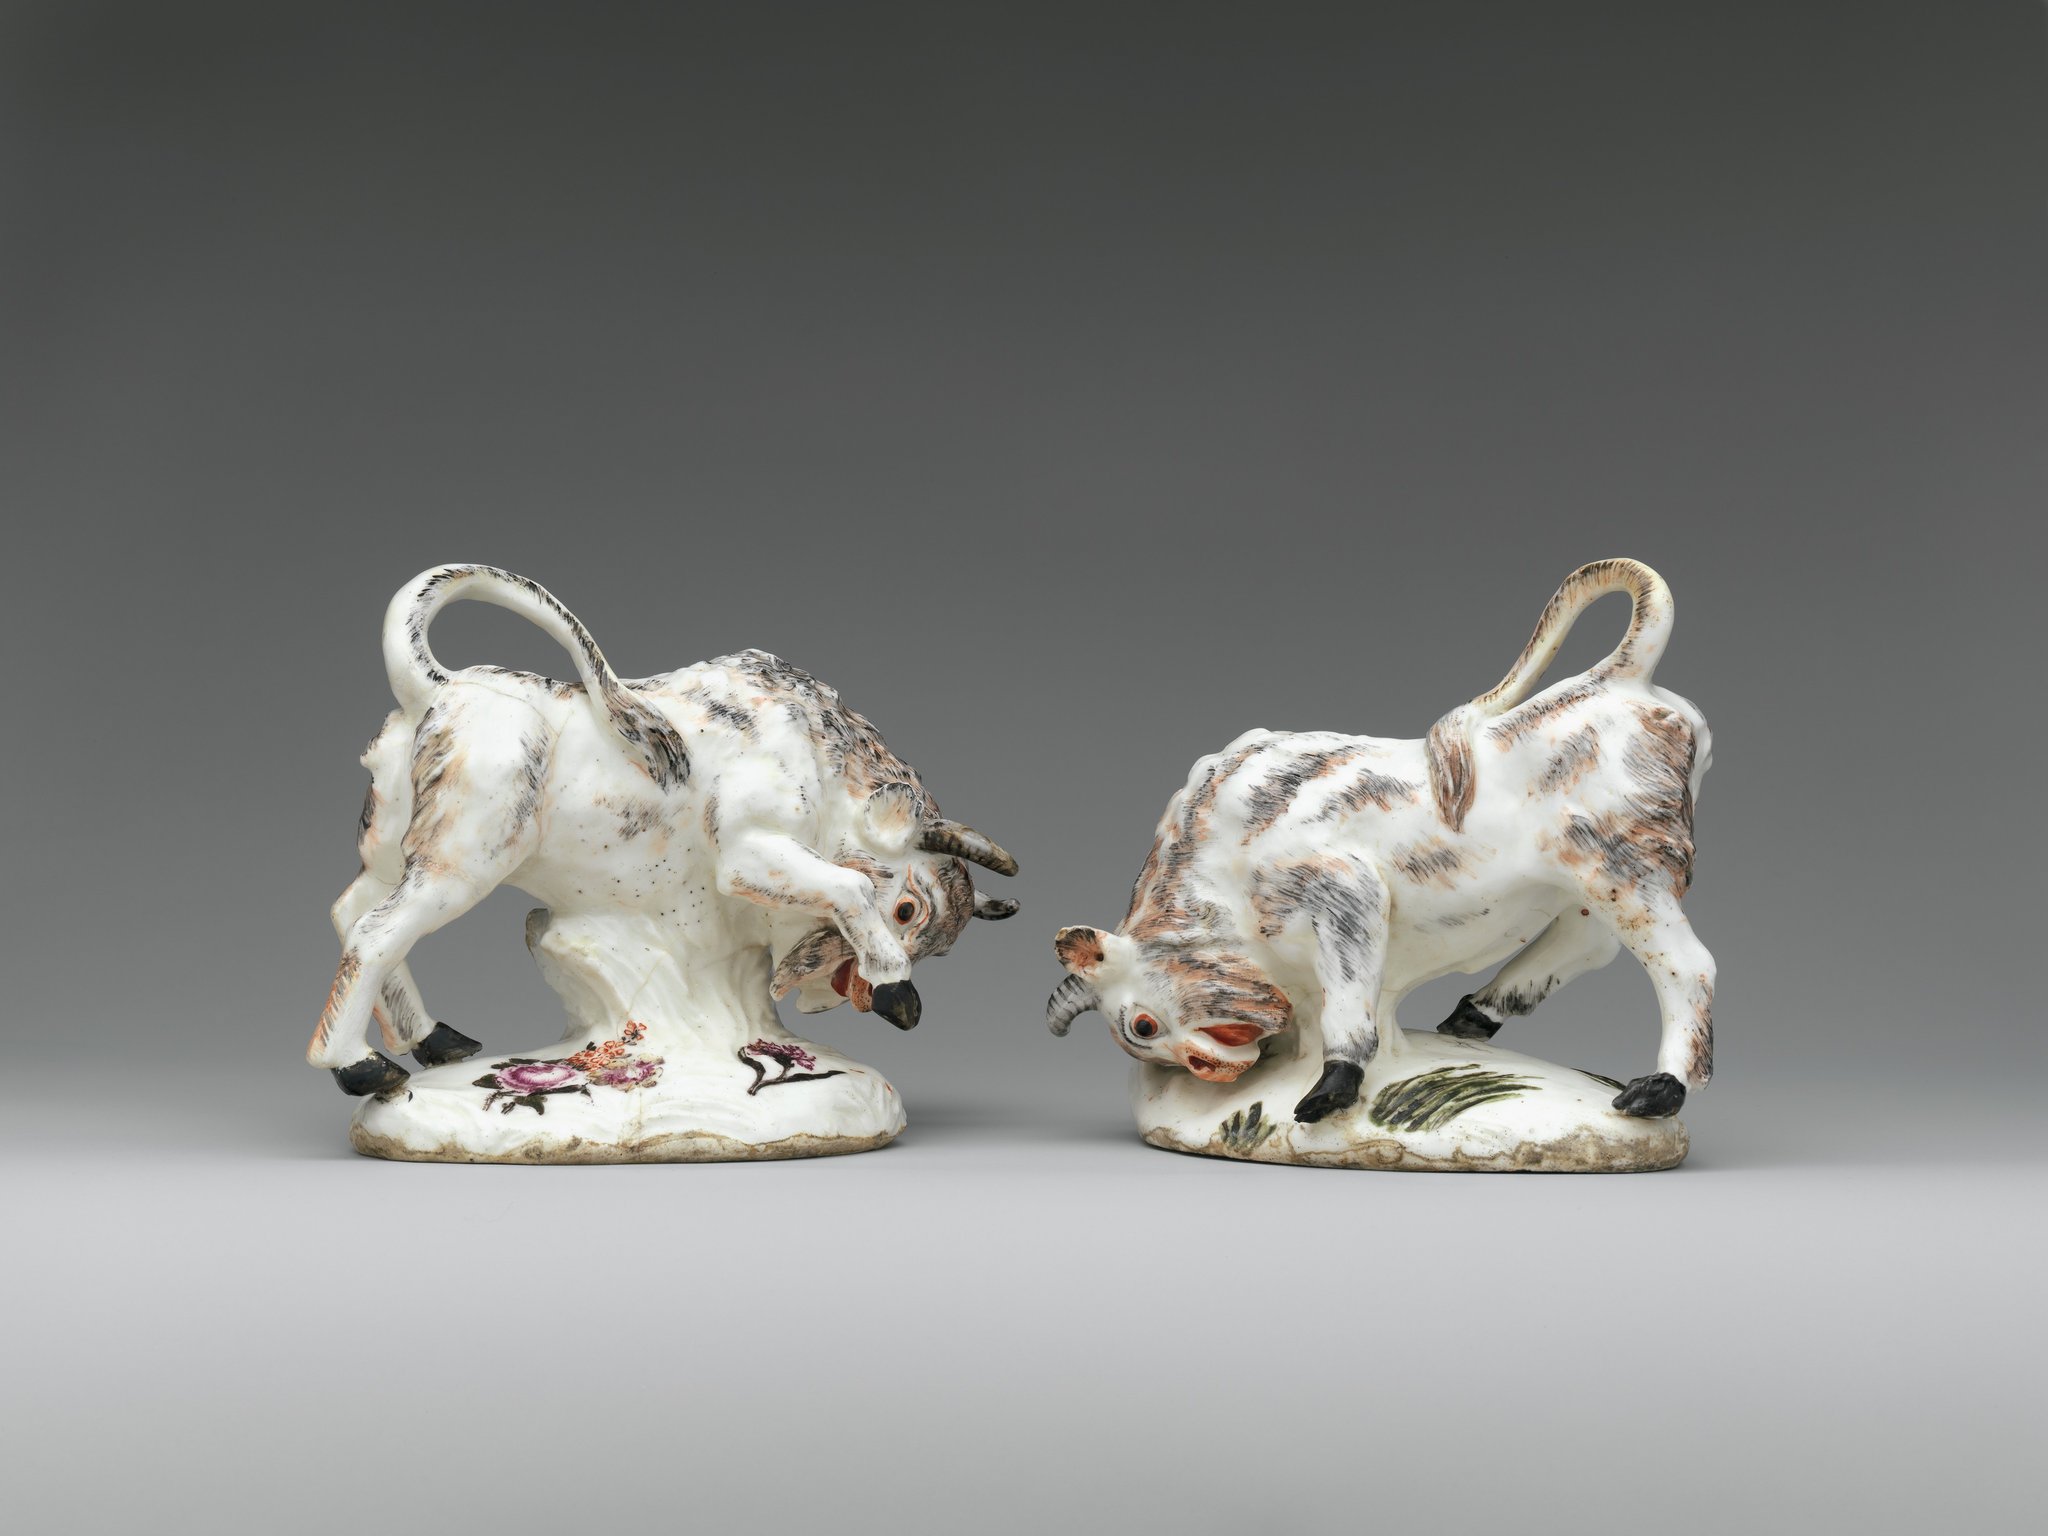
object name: figure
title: Charging bull (one of a pair)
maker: derby porcelain manufactory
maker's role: manufactory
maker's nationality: british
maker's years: 1751-1785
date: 1750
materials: soft paste porcelain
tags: bulls